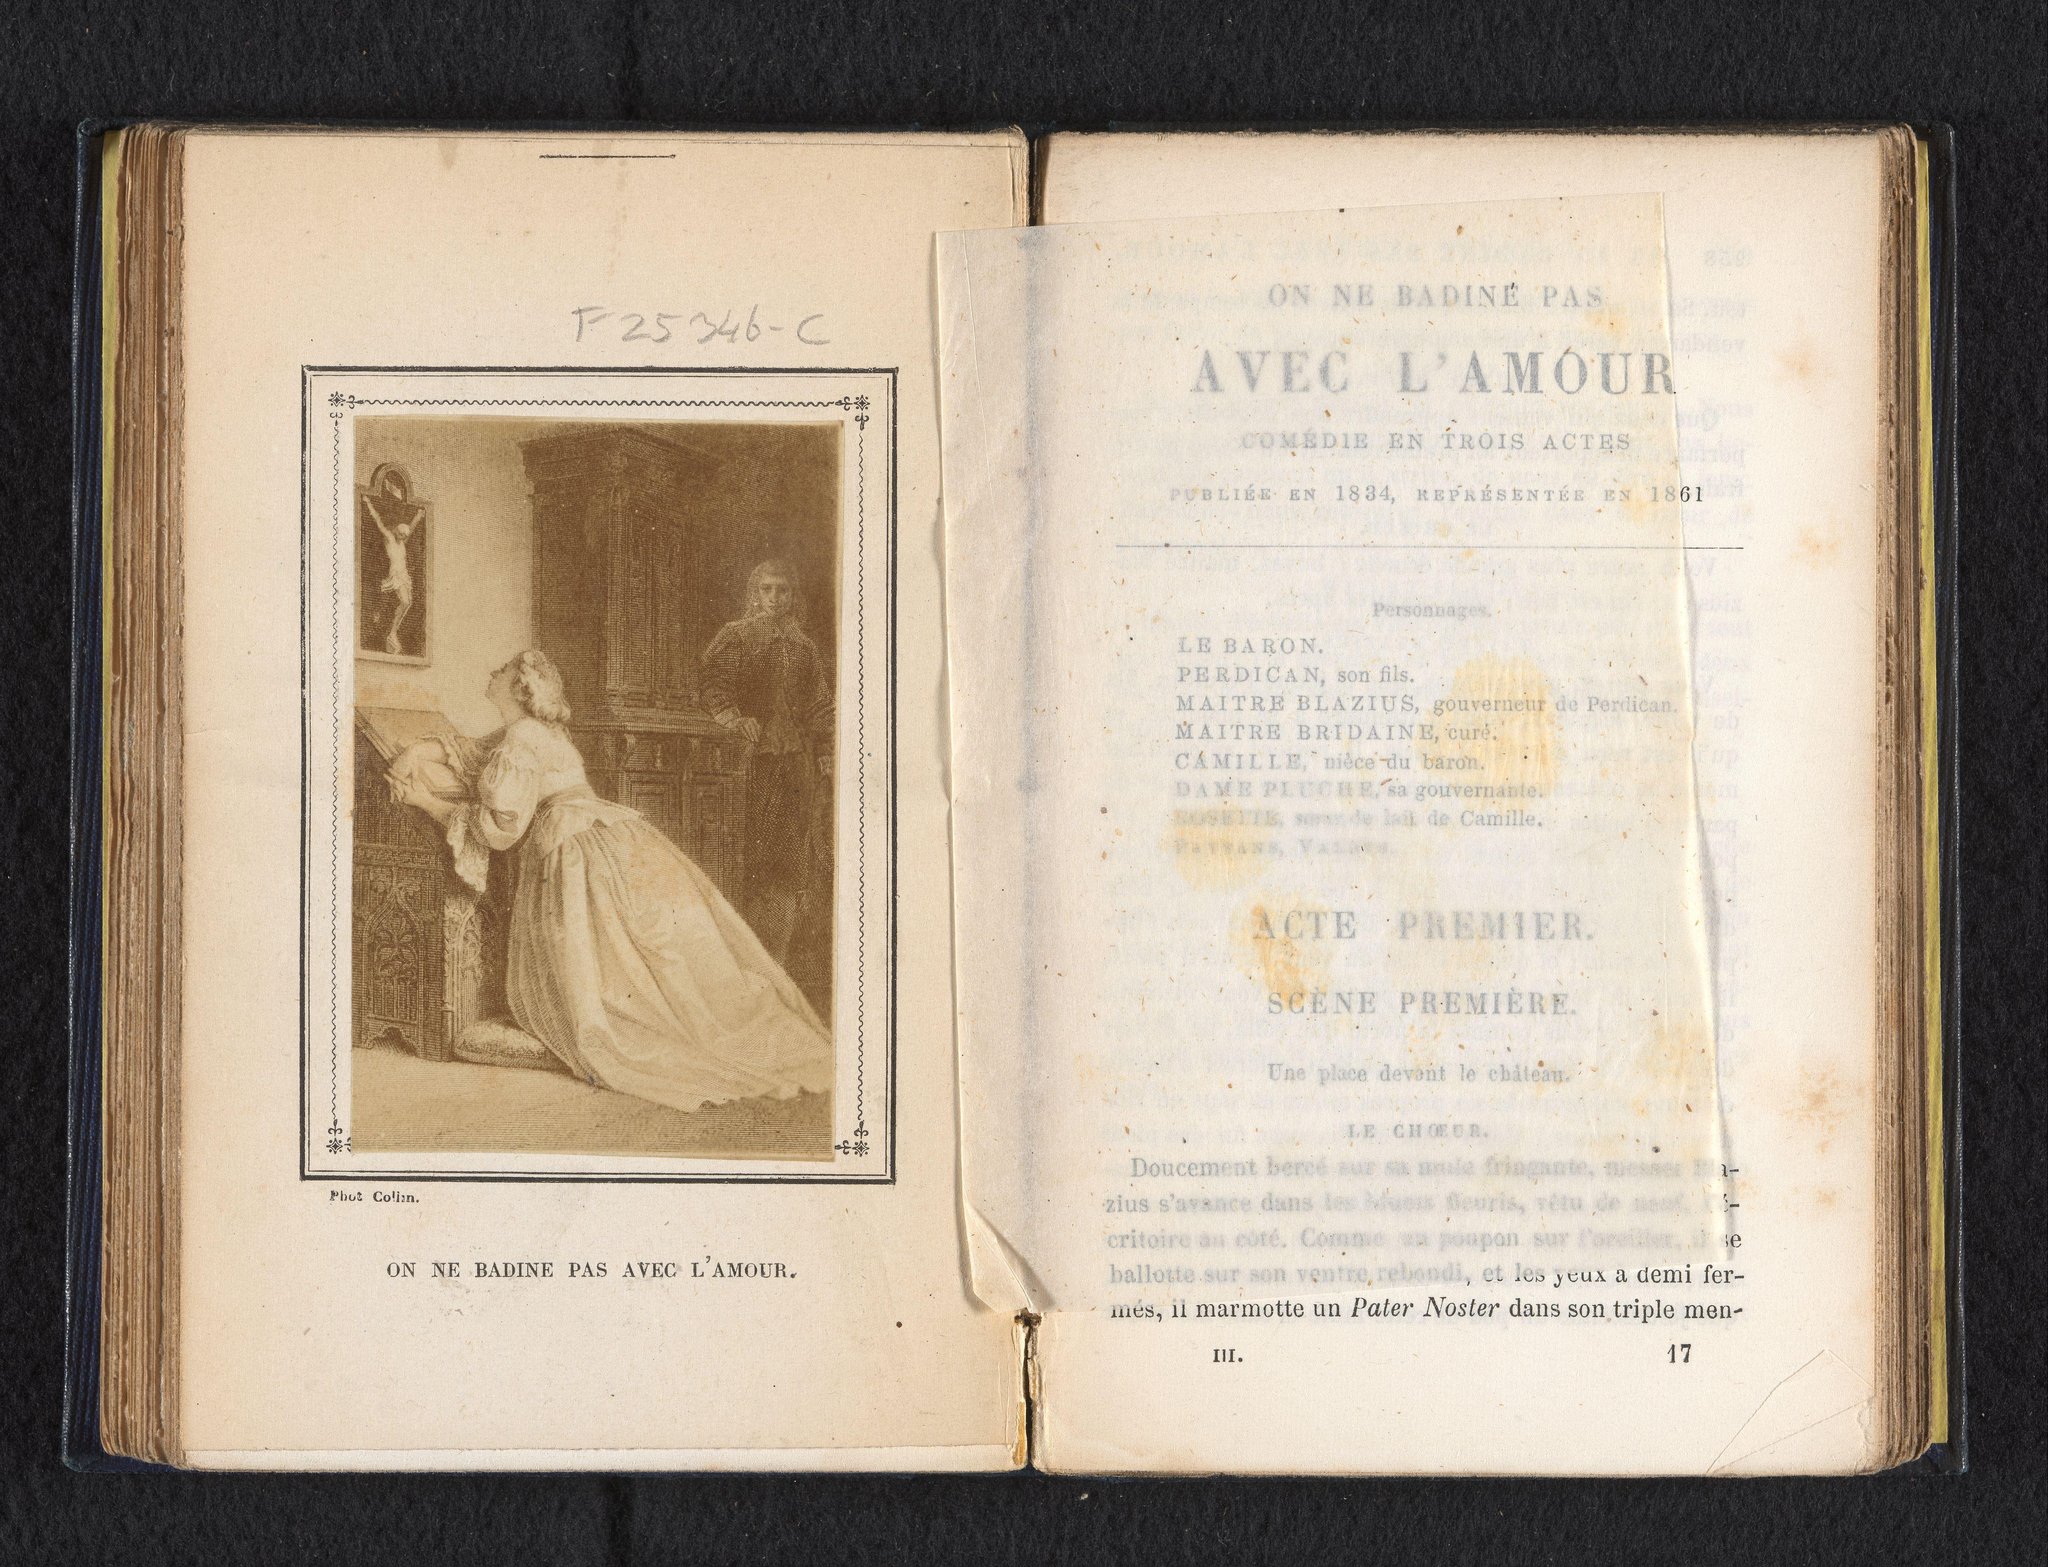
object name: photograph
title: On ne badine pas avec l'amour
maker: collin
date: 1852-1867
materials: paper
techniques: albumen print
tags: print, e.g.: engraving, etching, lithograph